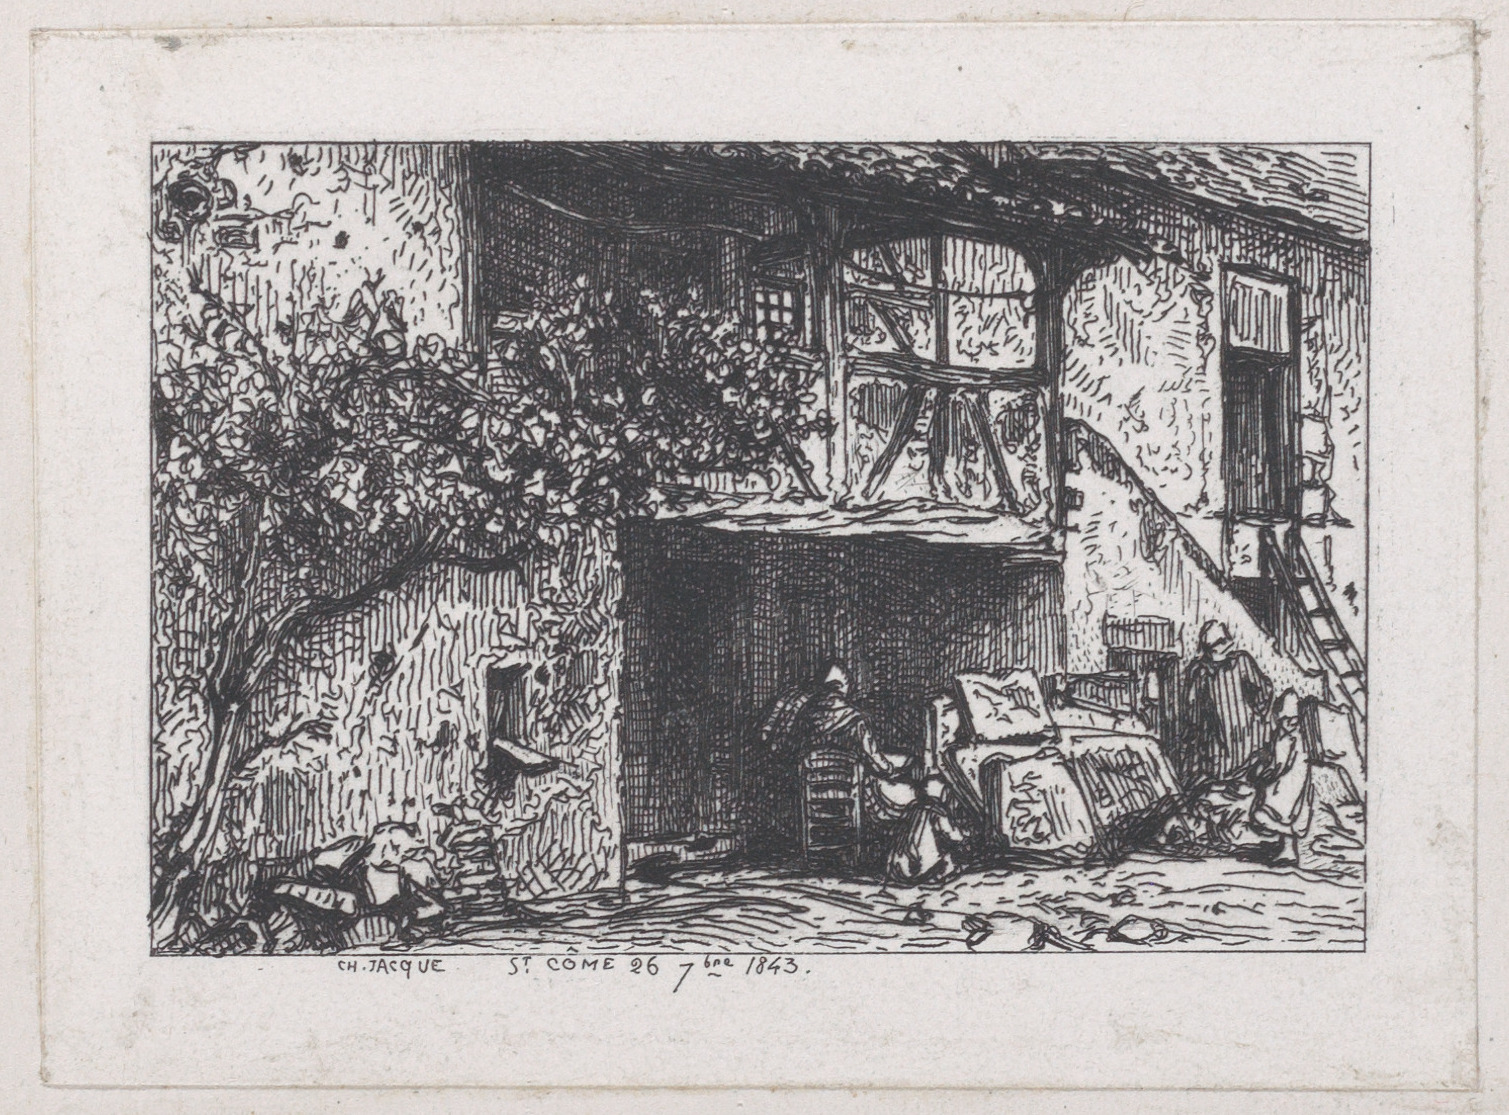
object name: print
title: House at Saint-Cômte and Drinker at the Barrel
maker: charles émile jacque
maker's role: artist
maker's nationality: french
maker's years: 1813-1894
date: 1843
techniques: etching